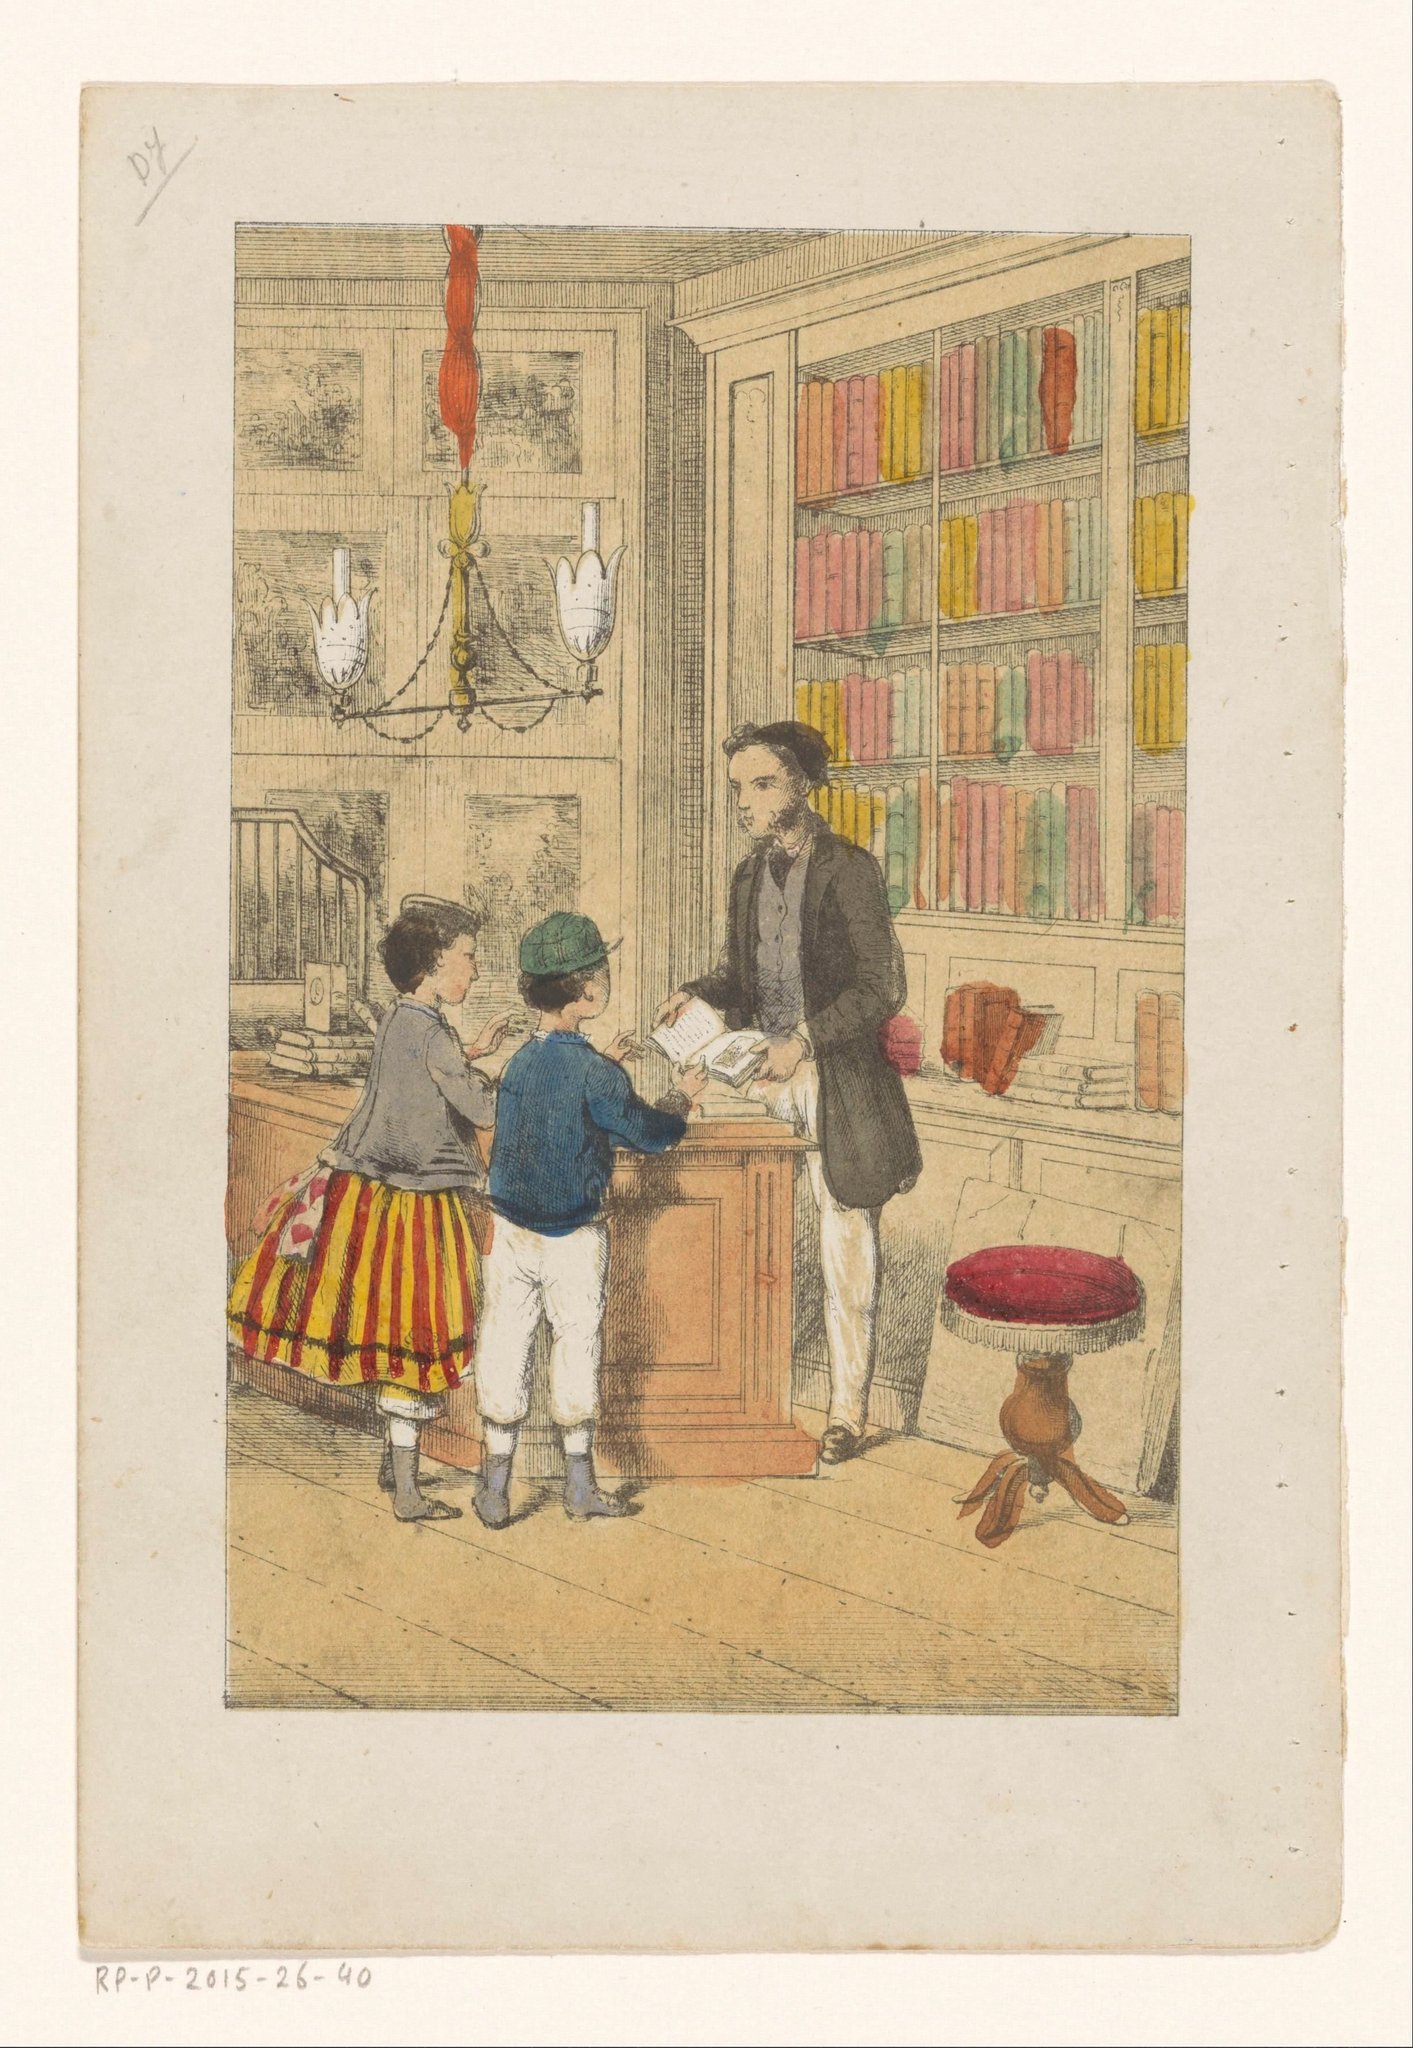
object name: book illustration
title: Twee kinderen in een boekhandel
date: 1868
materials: paper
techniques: hand coloring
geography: leiden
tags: children's books, book-shop, bookseller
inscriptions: collector's mark: Lugt 4780, collector's mark: Lugt 2228, collector's mark: Lugt 4779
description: Prent gebruikt in: Dercksen, Jacobus Marinus Everardus. De St. Nicolaas-avond. Leiden: D. Noothoven van Goor. Waarschijnlijk de eerste druk uit 1868.